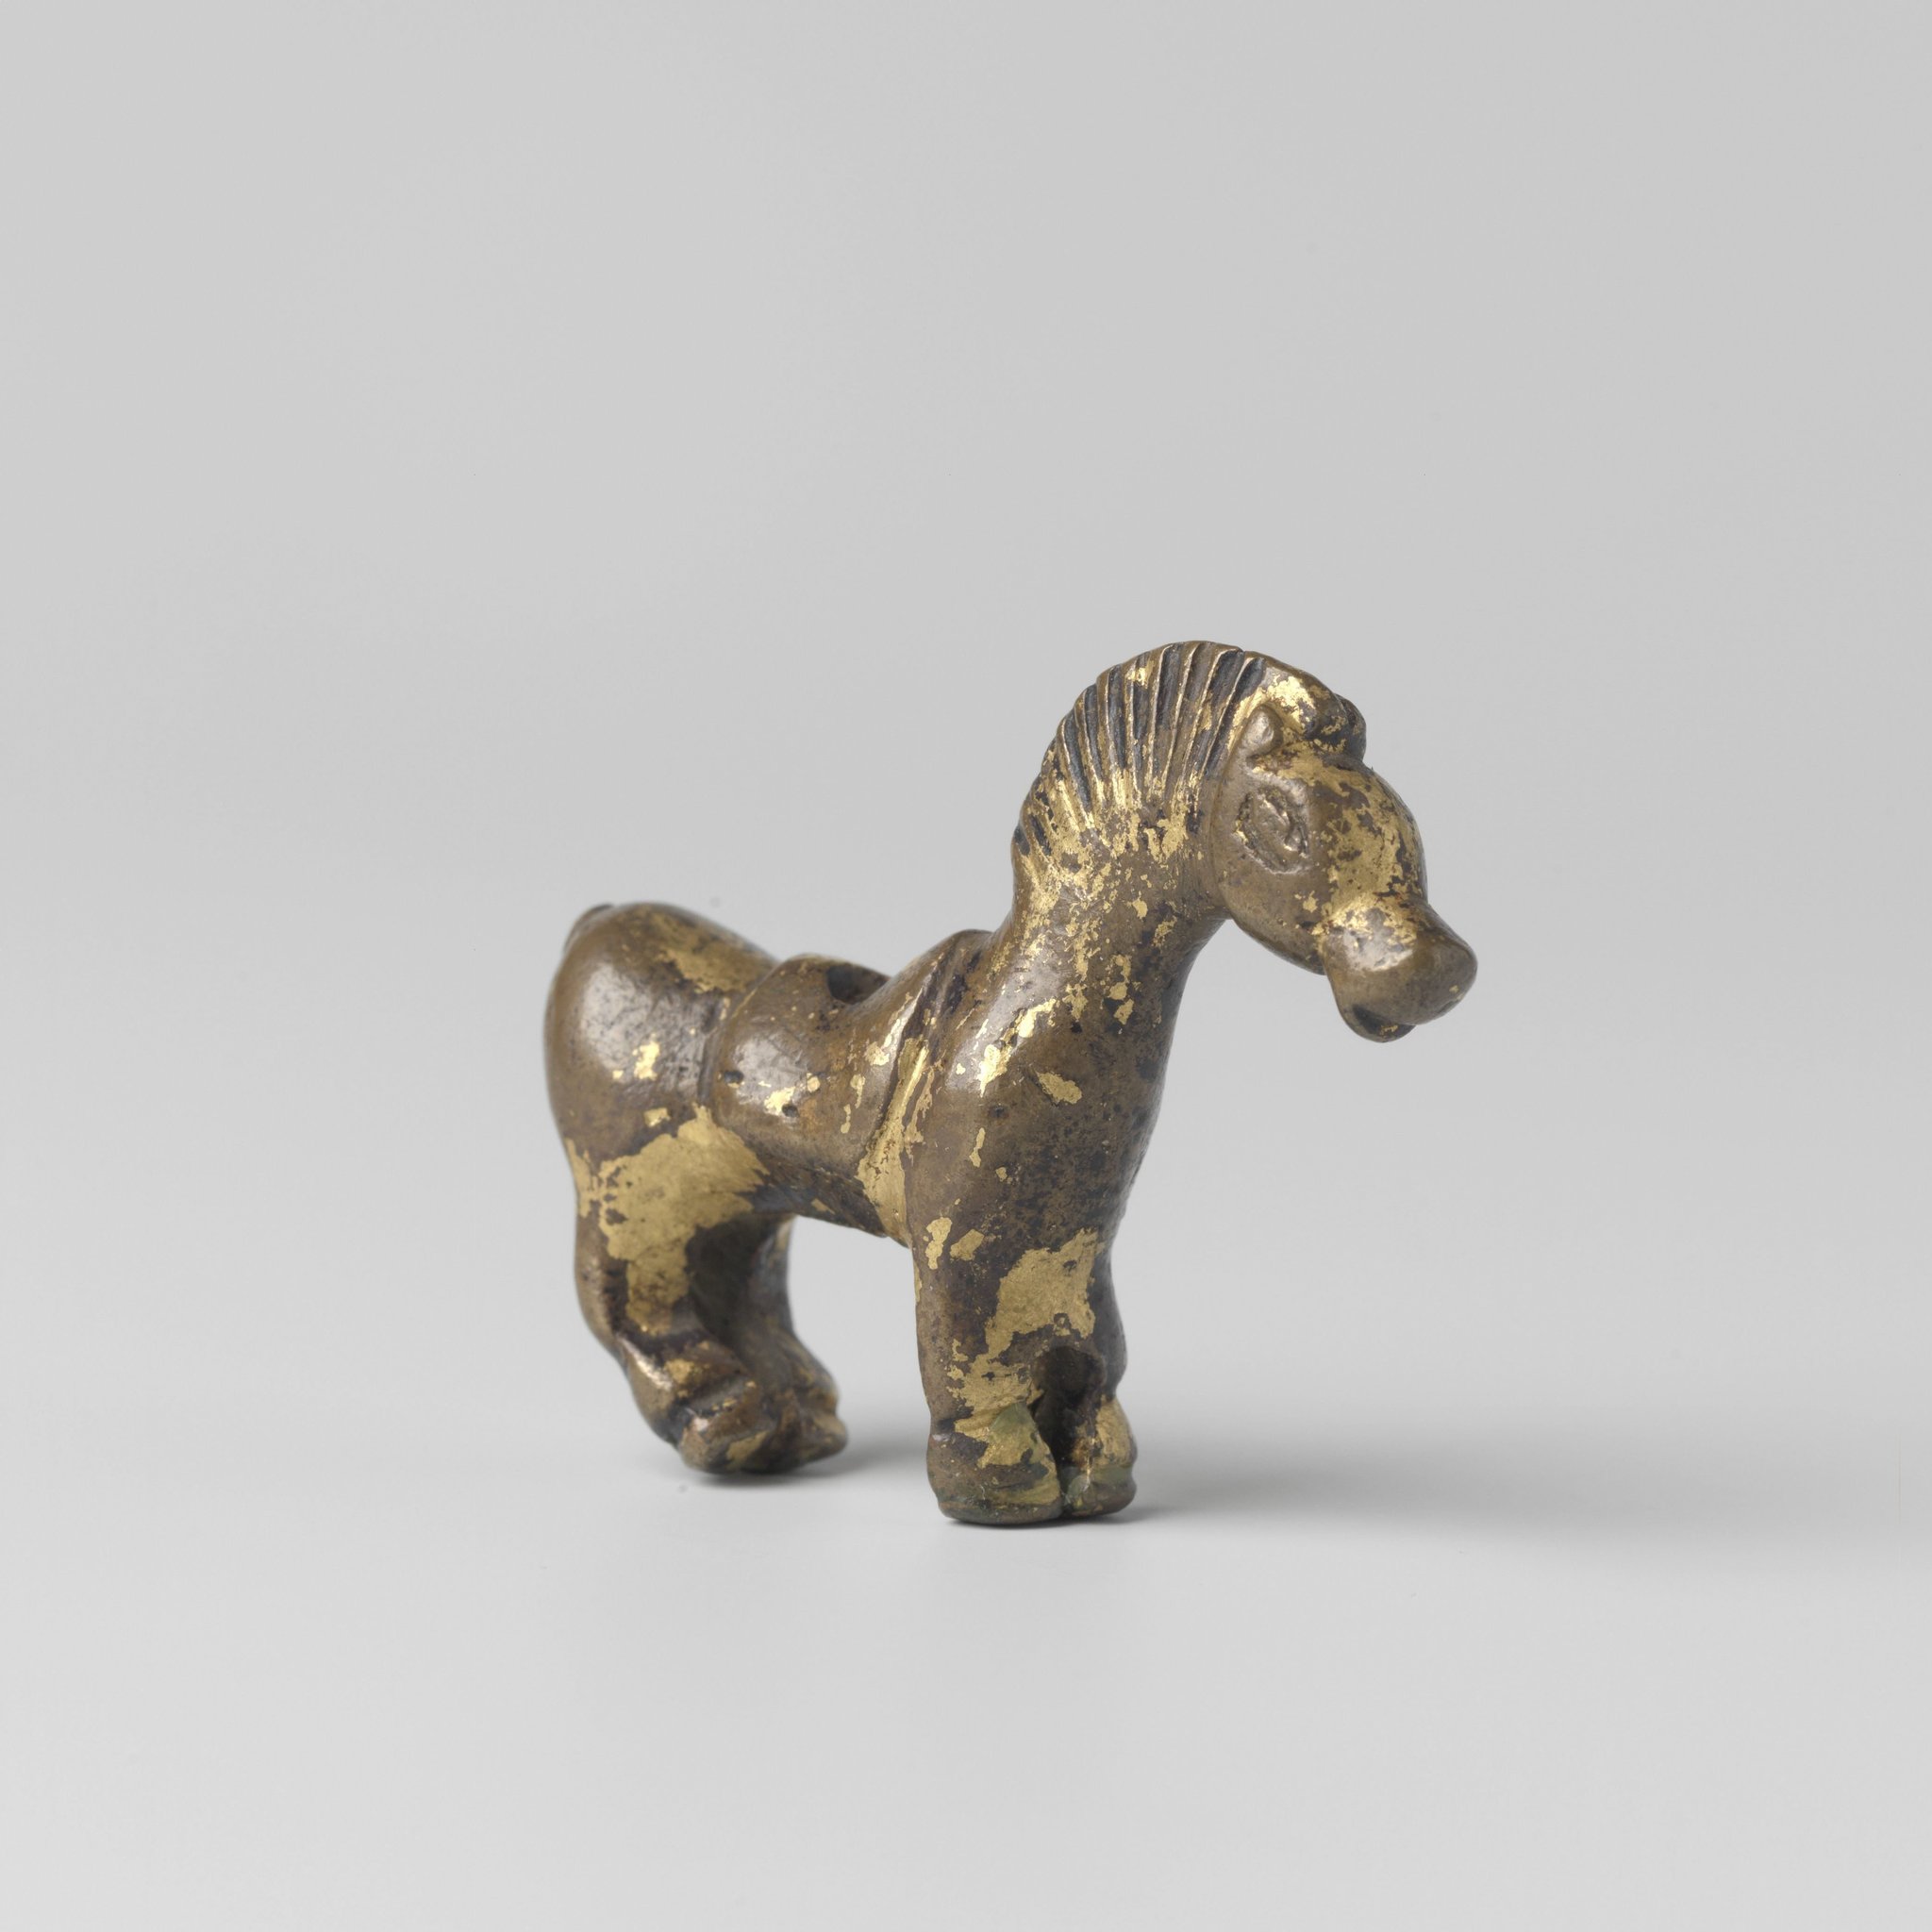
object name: figure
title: Paard van verguld brons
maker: Anonymous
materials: bronze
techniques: gilding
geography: ordos plateau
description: Horse. China, Ordos region. Late Eastern Zhou period (481 - 222 BC). Bronze gilt. Given by R. Flaes.